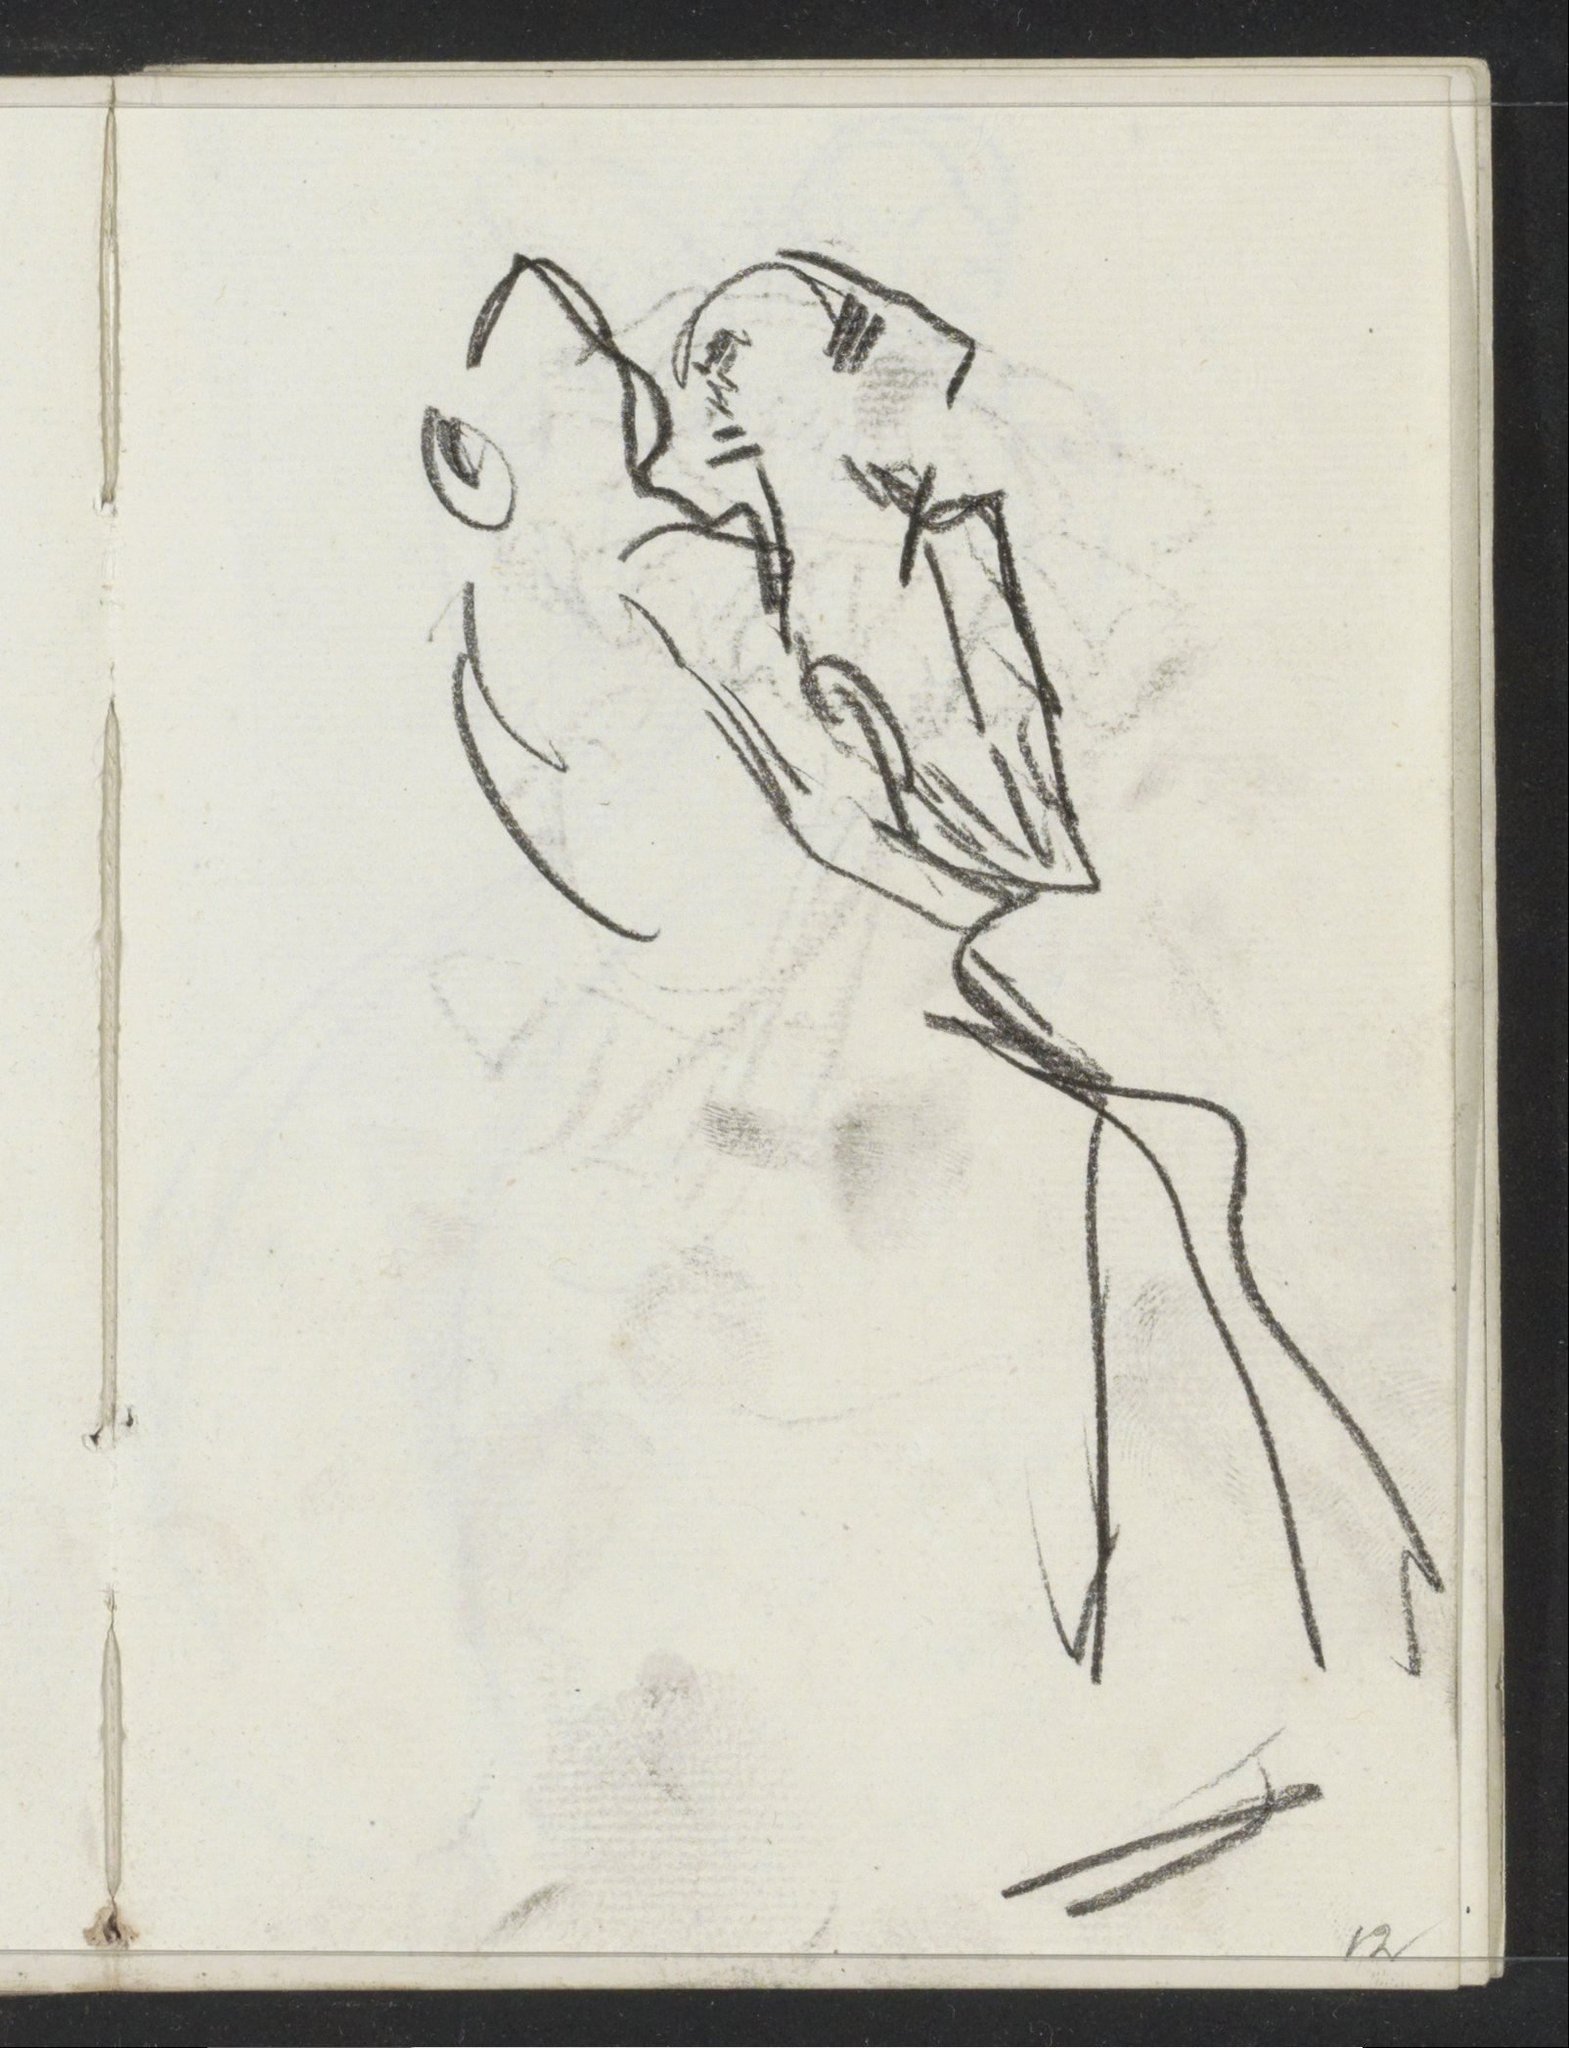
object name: sketchbook leaf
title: Twee dansende vrouwen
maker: isaac israels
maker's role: draughtsman, painter, print maker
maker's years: 1865-1934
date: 1886-1934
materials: chalk, paper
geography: amsterdam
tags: two women dancing as a couple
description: Blad 12 recto uit schetsboek LXIII met 23 bladen.